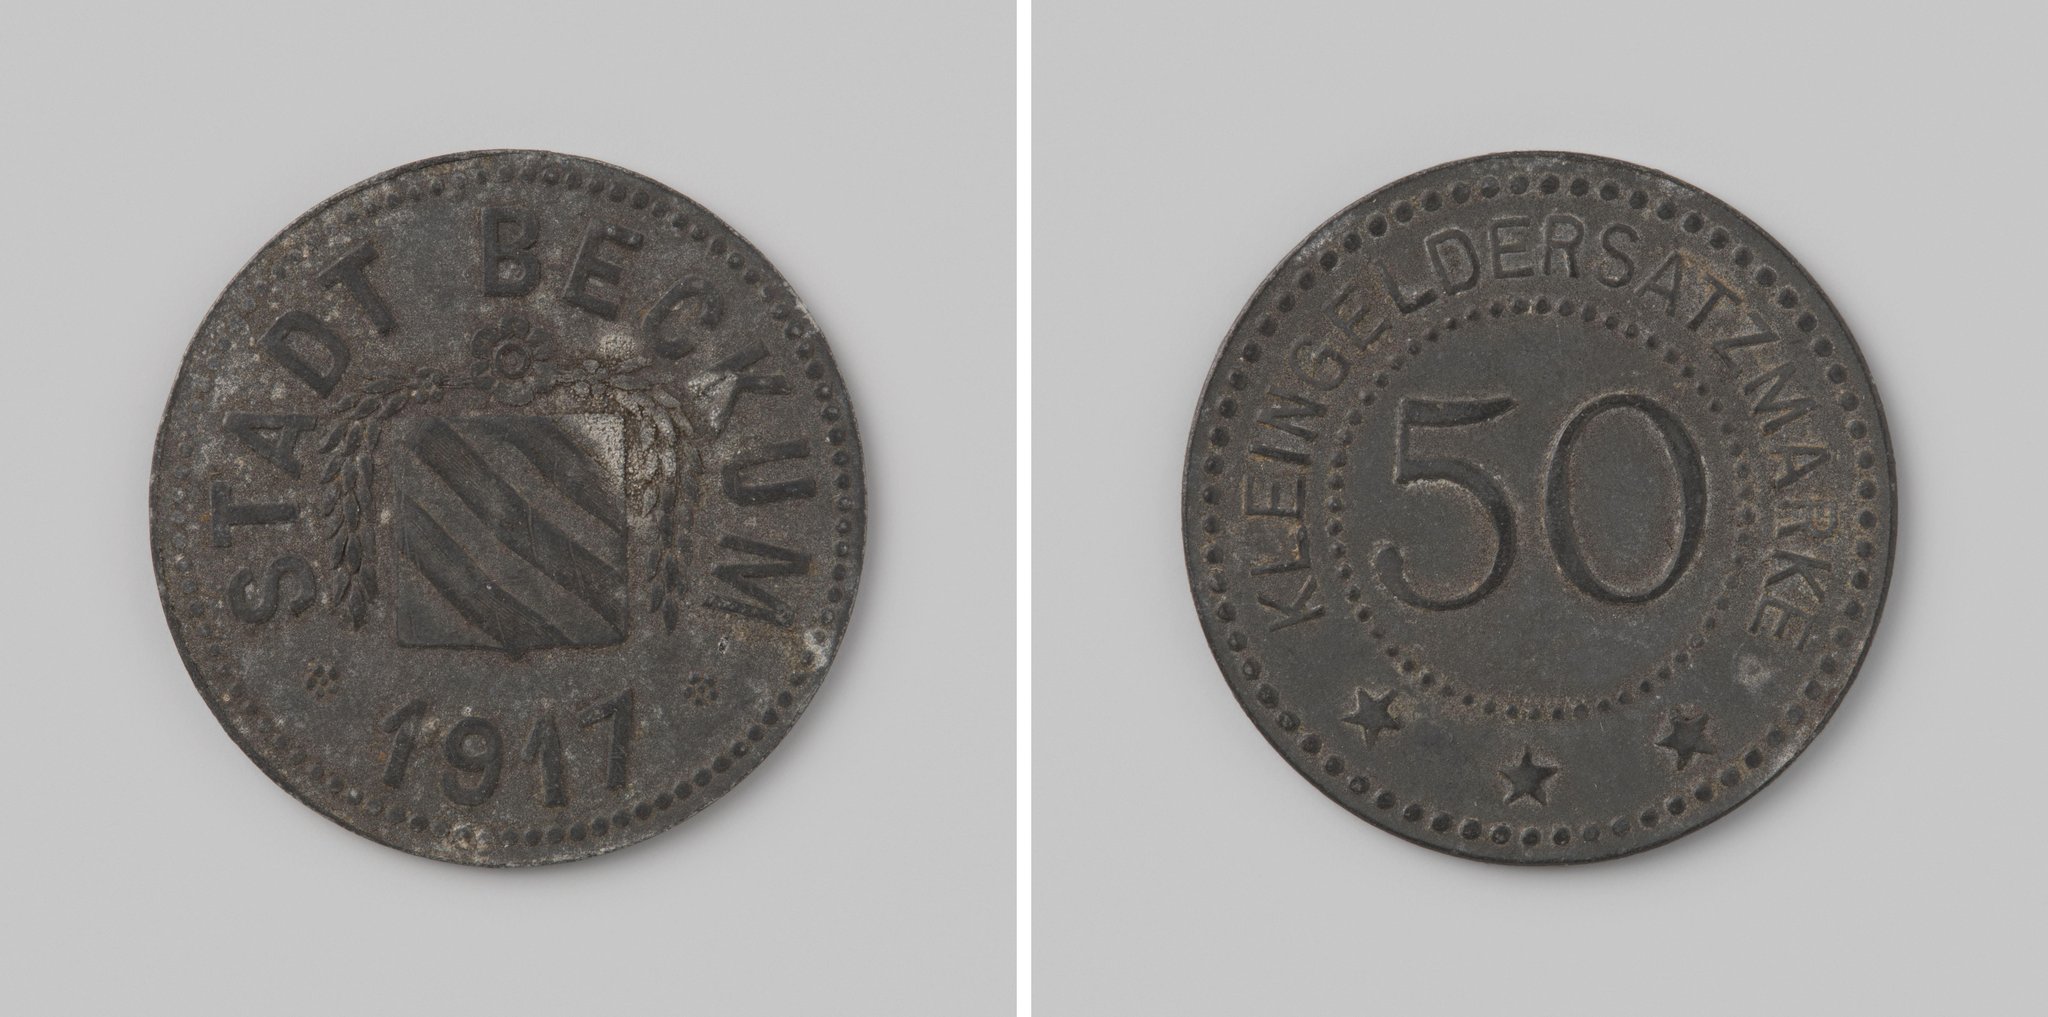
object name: vijftig pfennig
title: Vijftig pfennig uit Duitsland, noodmunt van de stadt Beckum, 1917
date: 1917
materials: zinc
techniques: striking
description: Zinken noodmunt. Voorzijde: onder krans wapenschild. Plaatsaanduiding en jaartal in omschrift. Keerzijde: waarde-aanduiding 50 in rond veld. Gladde lrand.